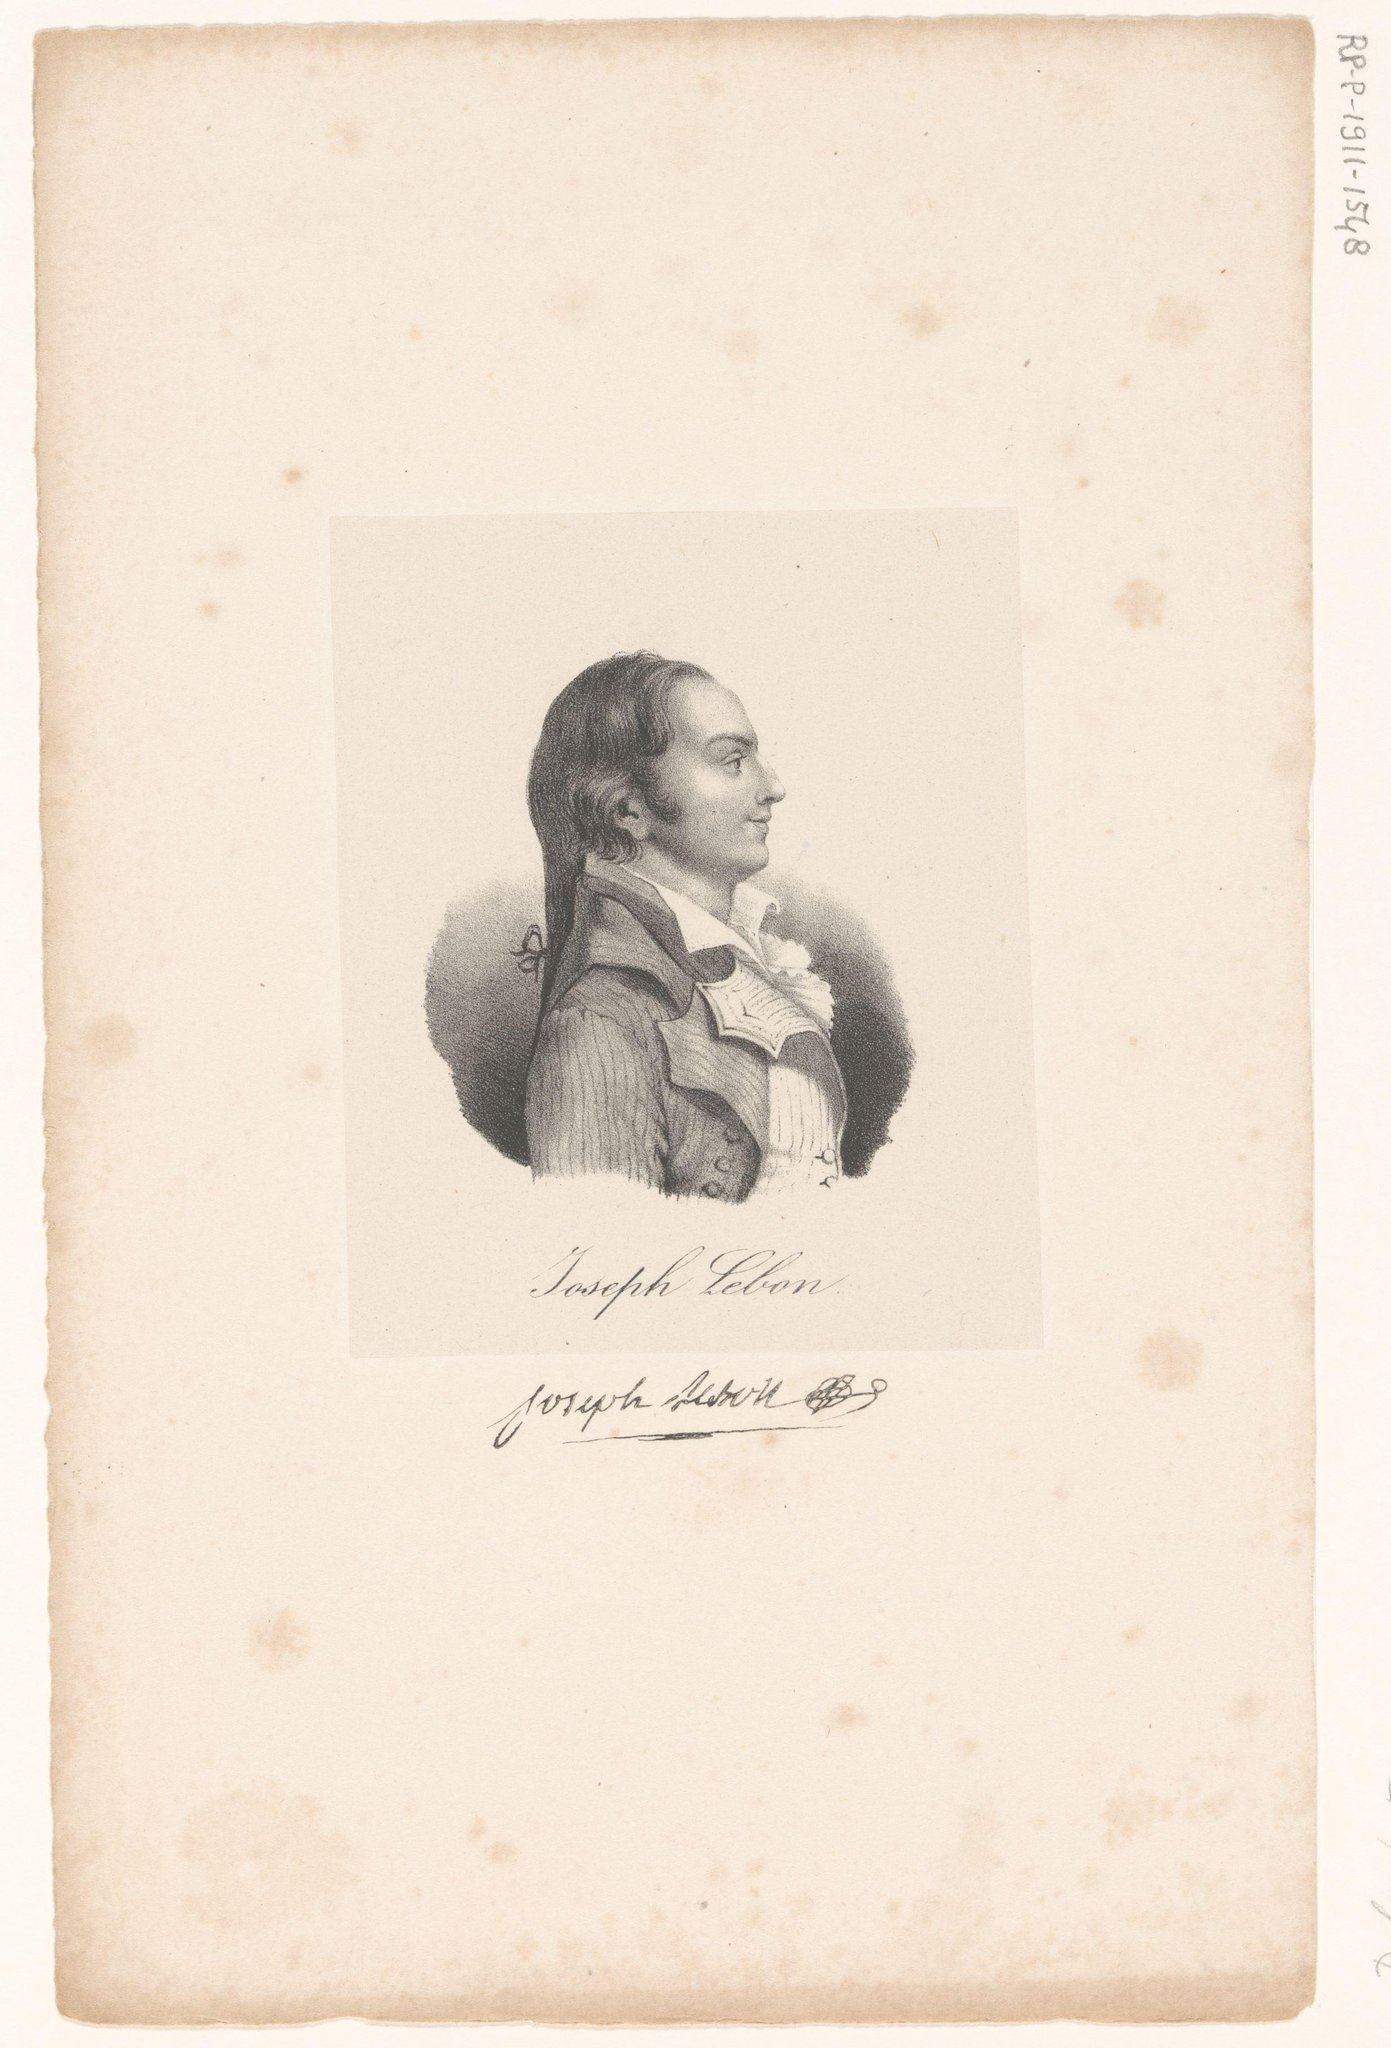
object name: print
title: Joseph Lebon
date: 1818-1842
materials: paper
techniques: lithograph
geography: paris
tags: politician, historical persons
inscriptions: collector's mark: Lugt 2228a